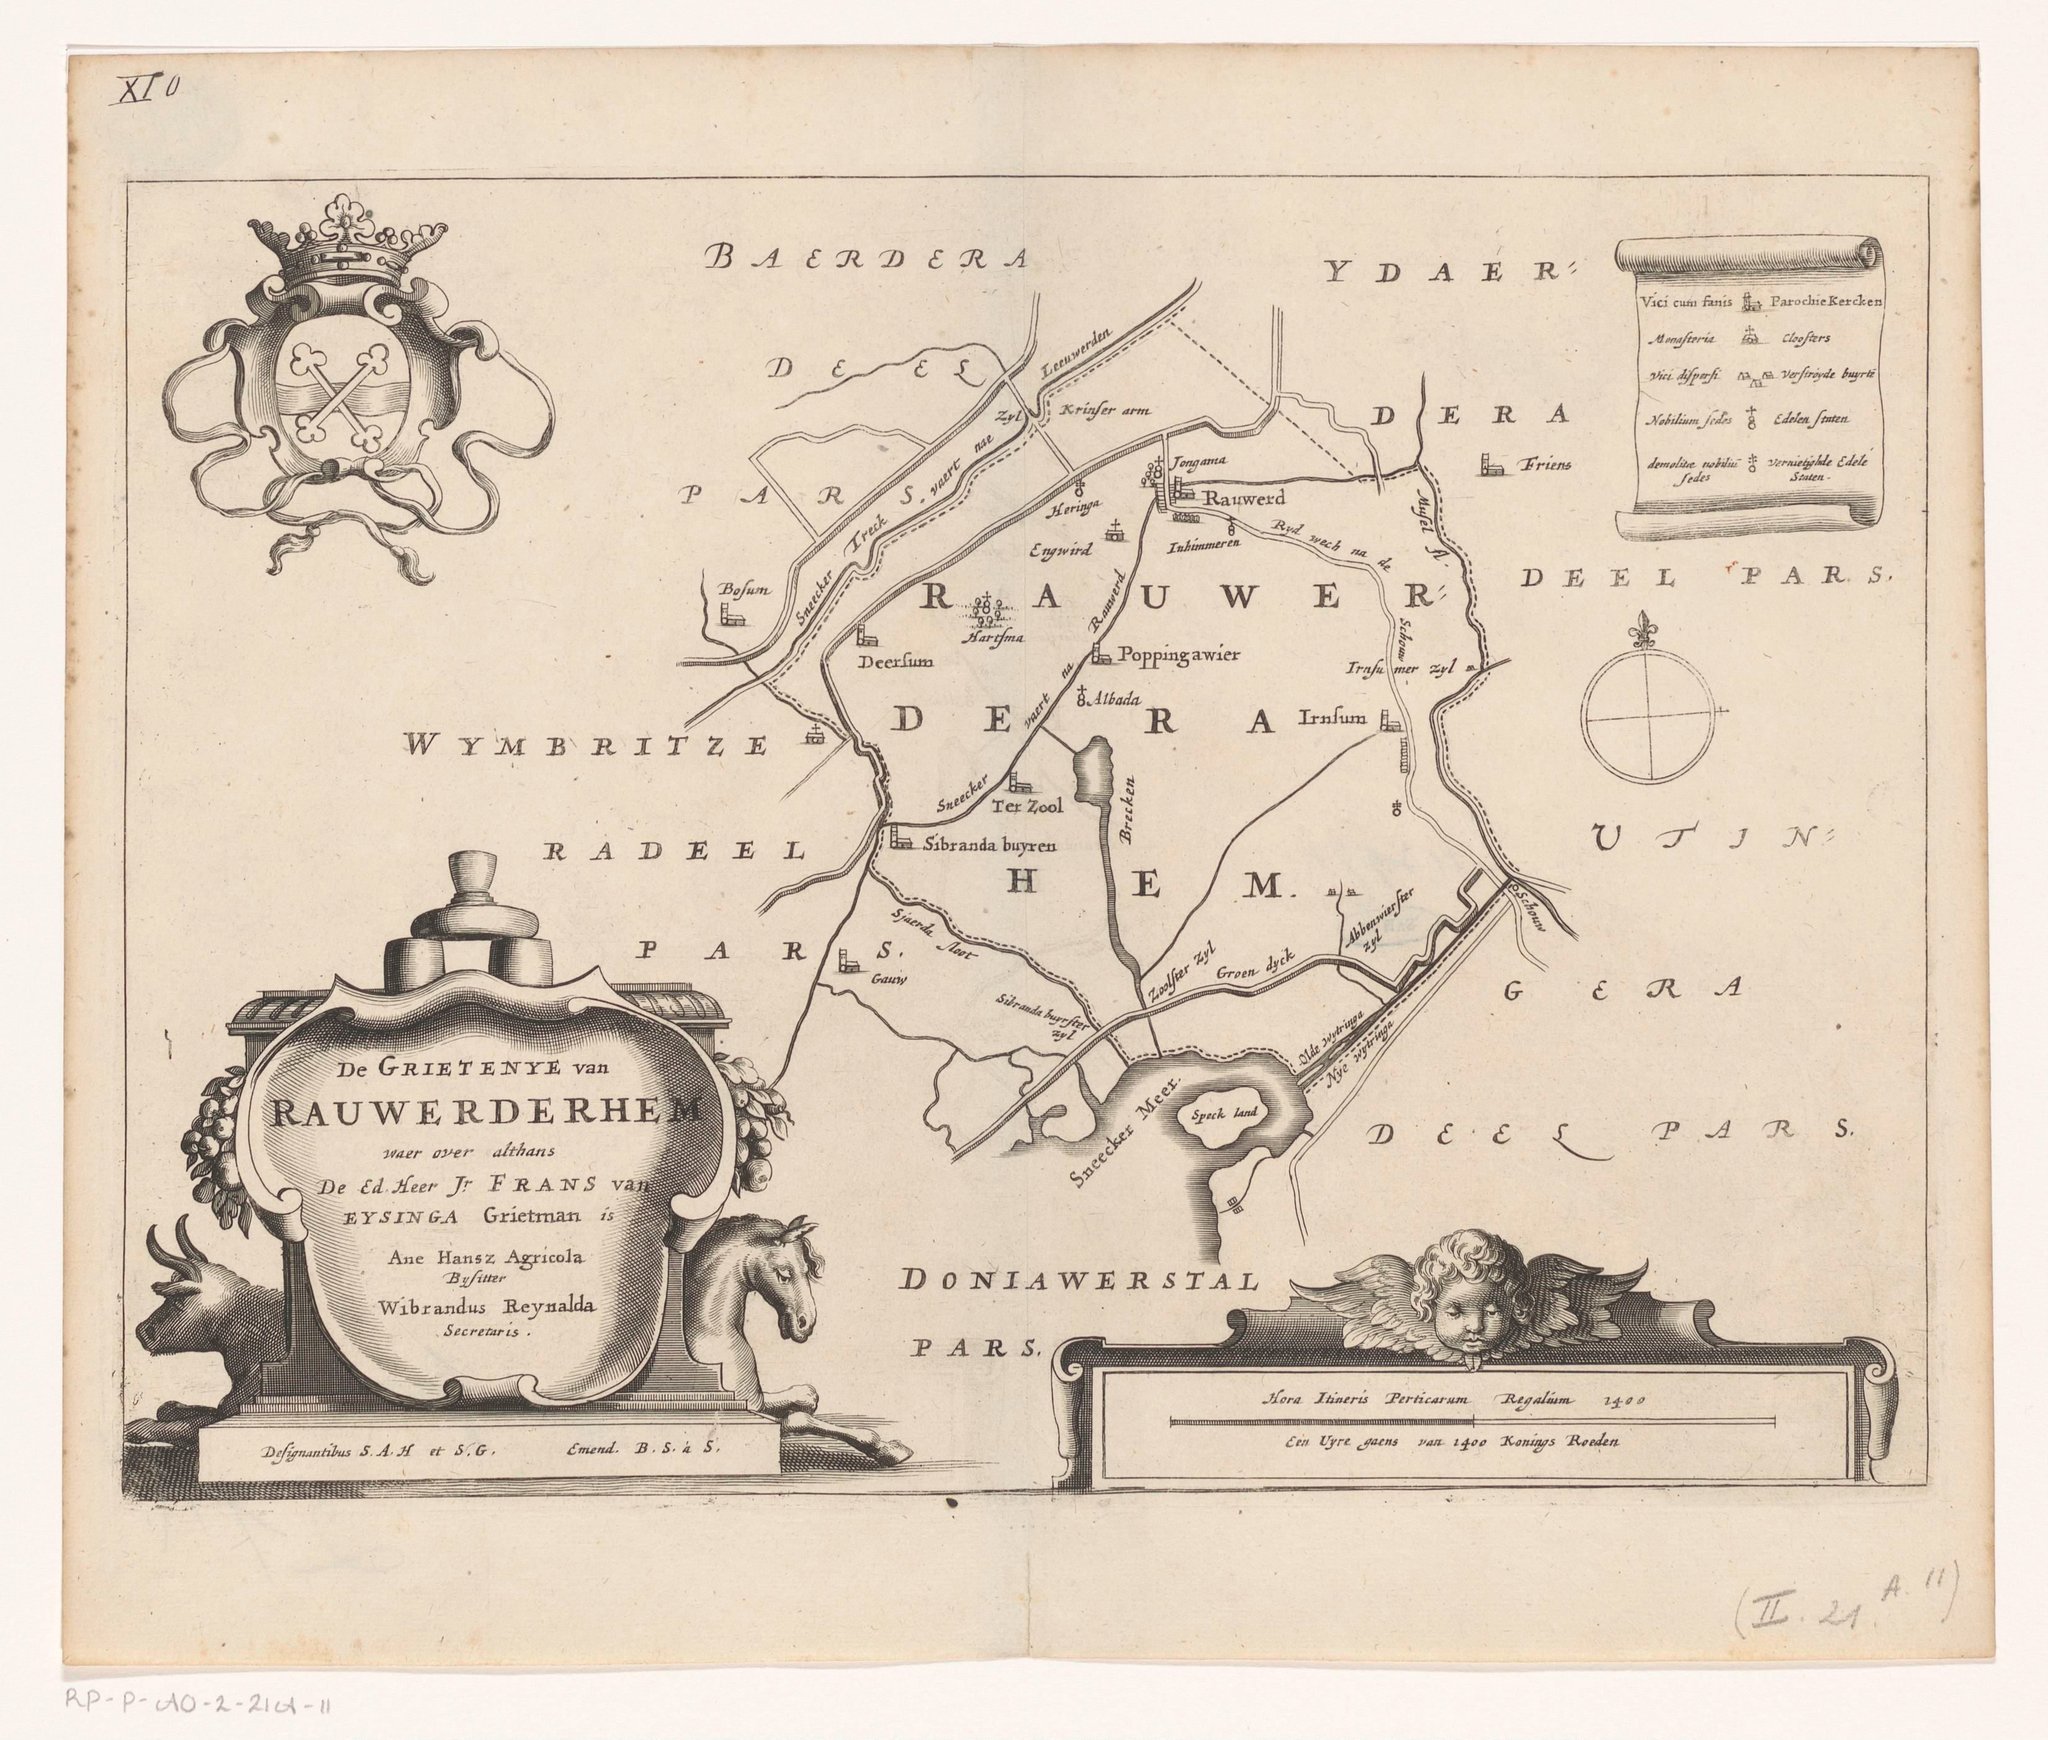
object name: print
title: De grietenye van Rauwerderhem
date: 1664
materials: paper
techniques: engraving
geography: friesland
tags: coat of arms (as symbol of the state, etc.), maps of separate countries or regions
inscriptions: collector's mark: Lugt 2228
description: Linksboven het wapen van Rauwerderhem, linksonder cartouche met titel en bestuurlijke informatie over de grietenij. Rechtsboven legenda, rechtsonder een schaalstok: Hora itineris perticarum regalium 1400 / Een uyre gaens van 1400 konings roeden.